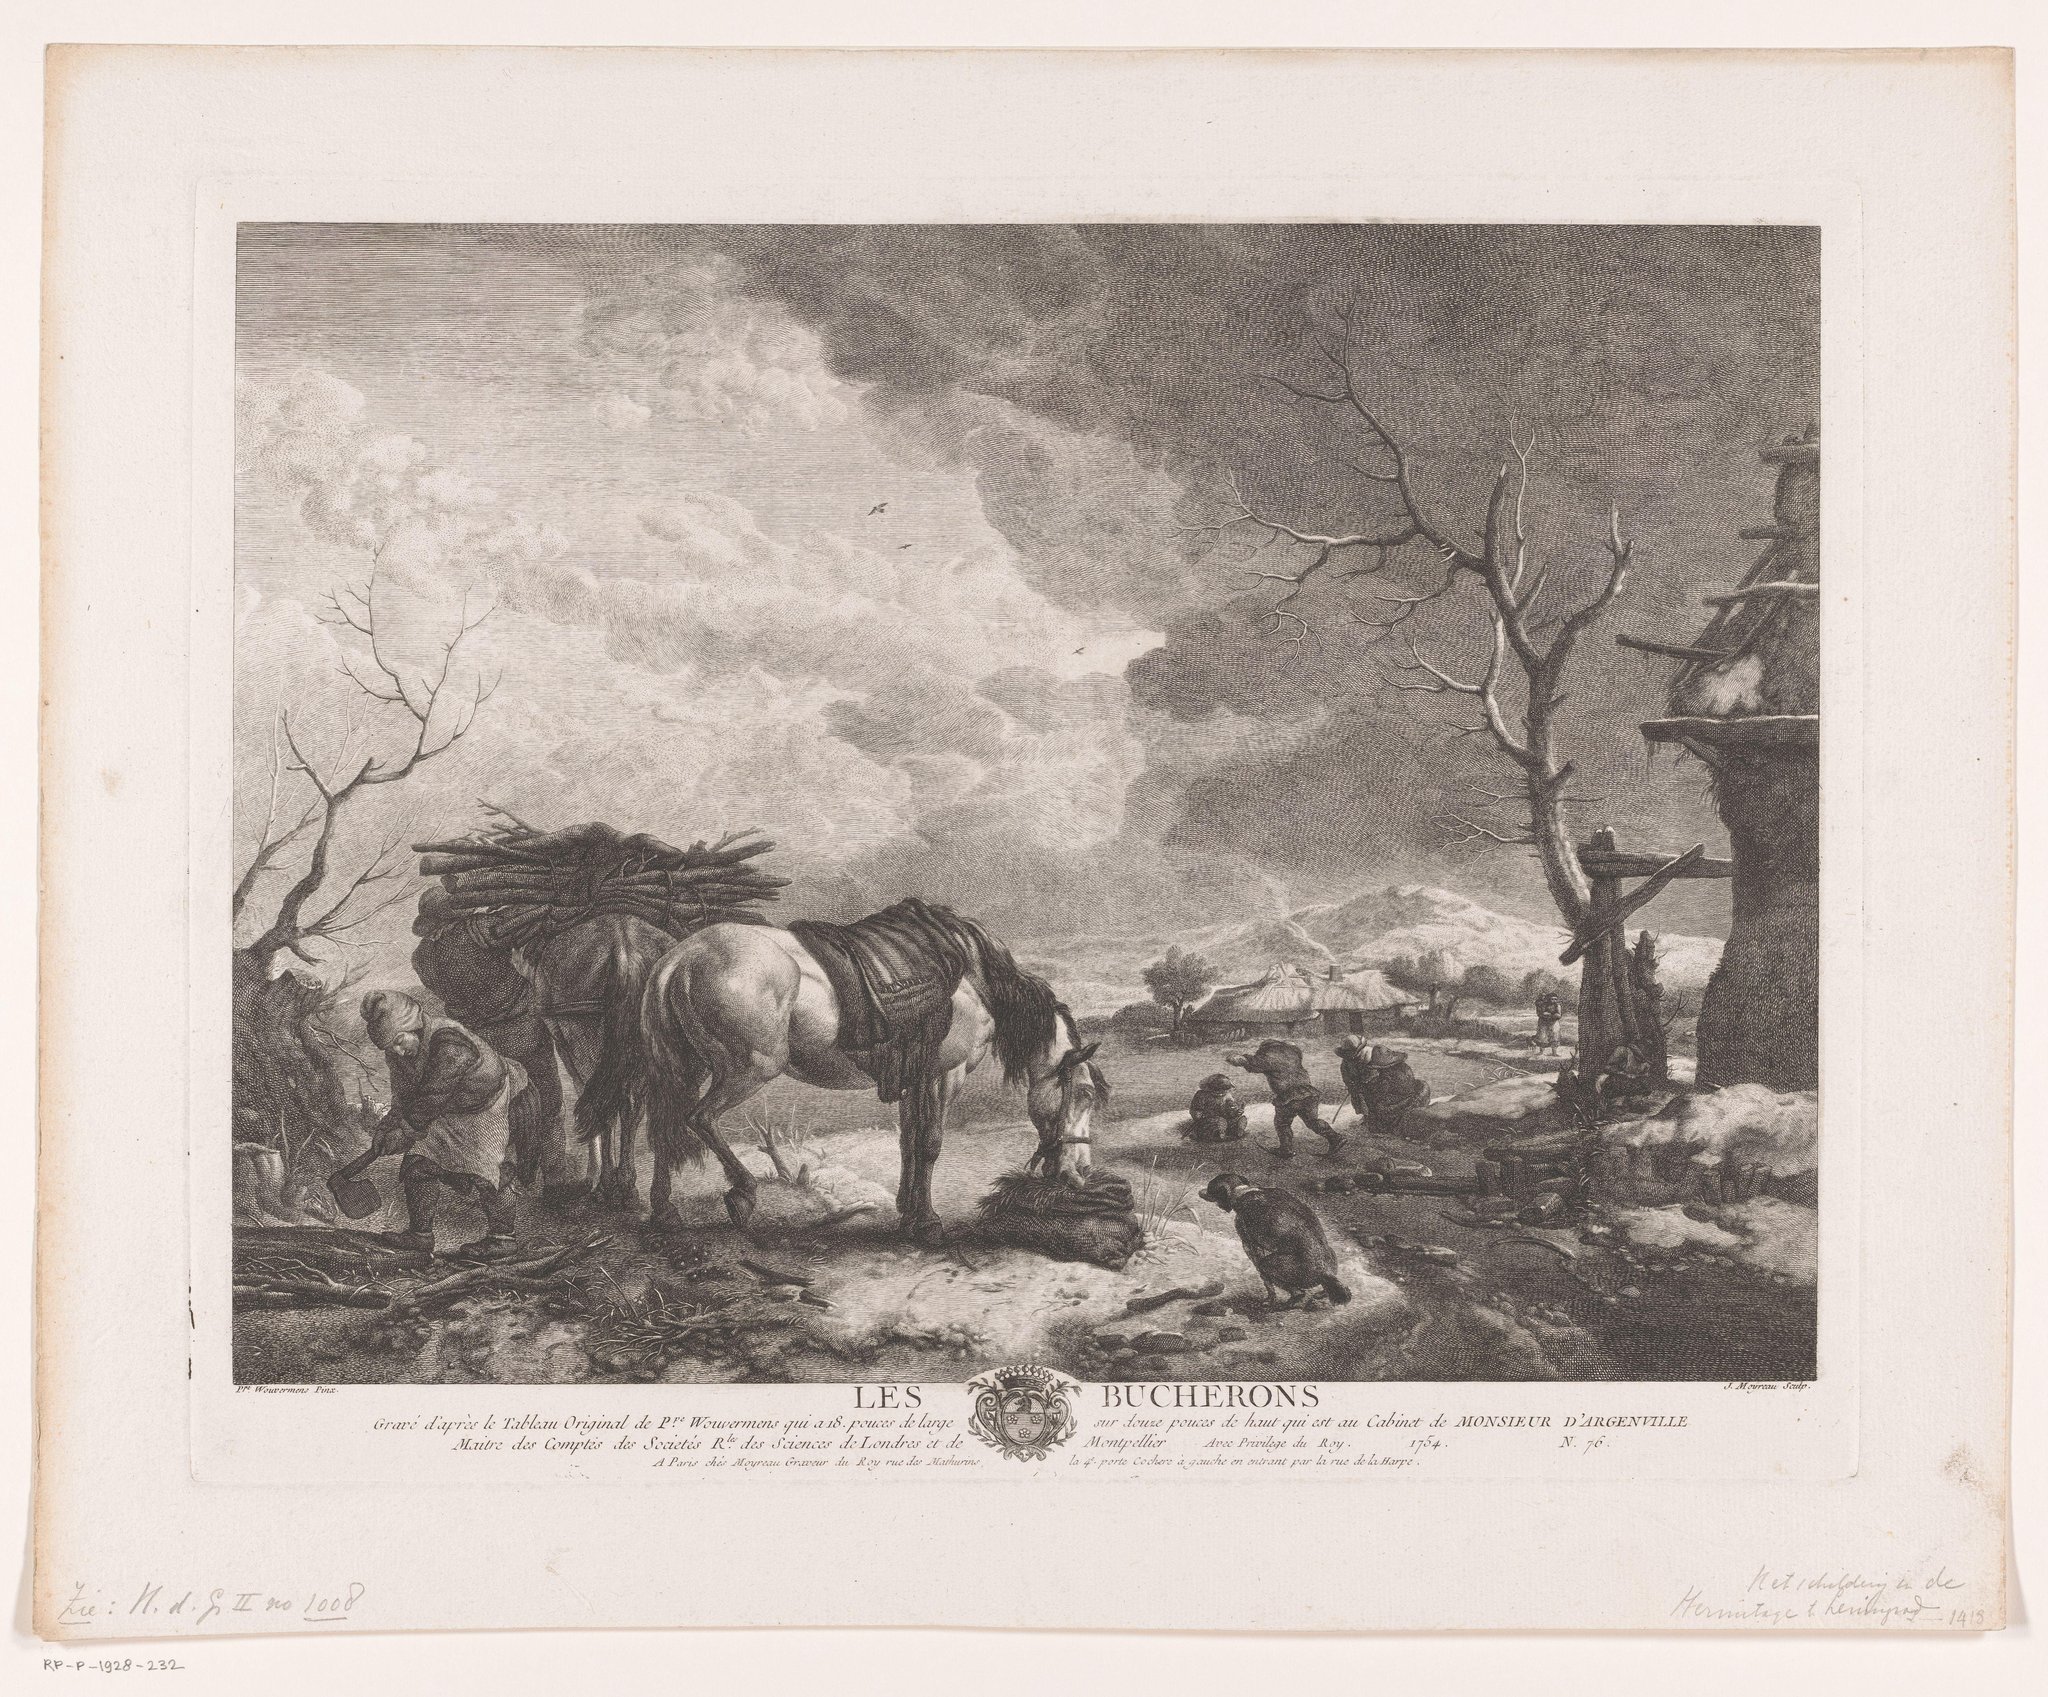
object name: print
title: Prenten naar schilderijen door Philips Wouwerman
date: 1754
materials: paper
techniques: engraving, etching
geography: paris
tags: woodcutting, woodcutter ~ forestry, winter ~ human activities (the four seasons of the year), tools, aids, implements ~ crafts and industries: axe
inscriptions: collector's mark: Lugt 2228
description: Maakt deel uit van een serie van 89 prenten te dateren tussen ca. 1733-1762, naar het geschilderde oeuvre van Philips Wouwerman. Dit betreft plaat 76.